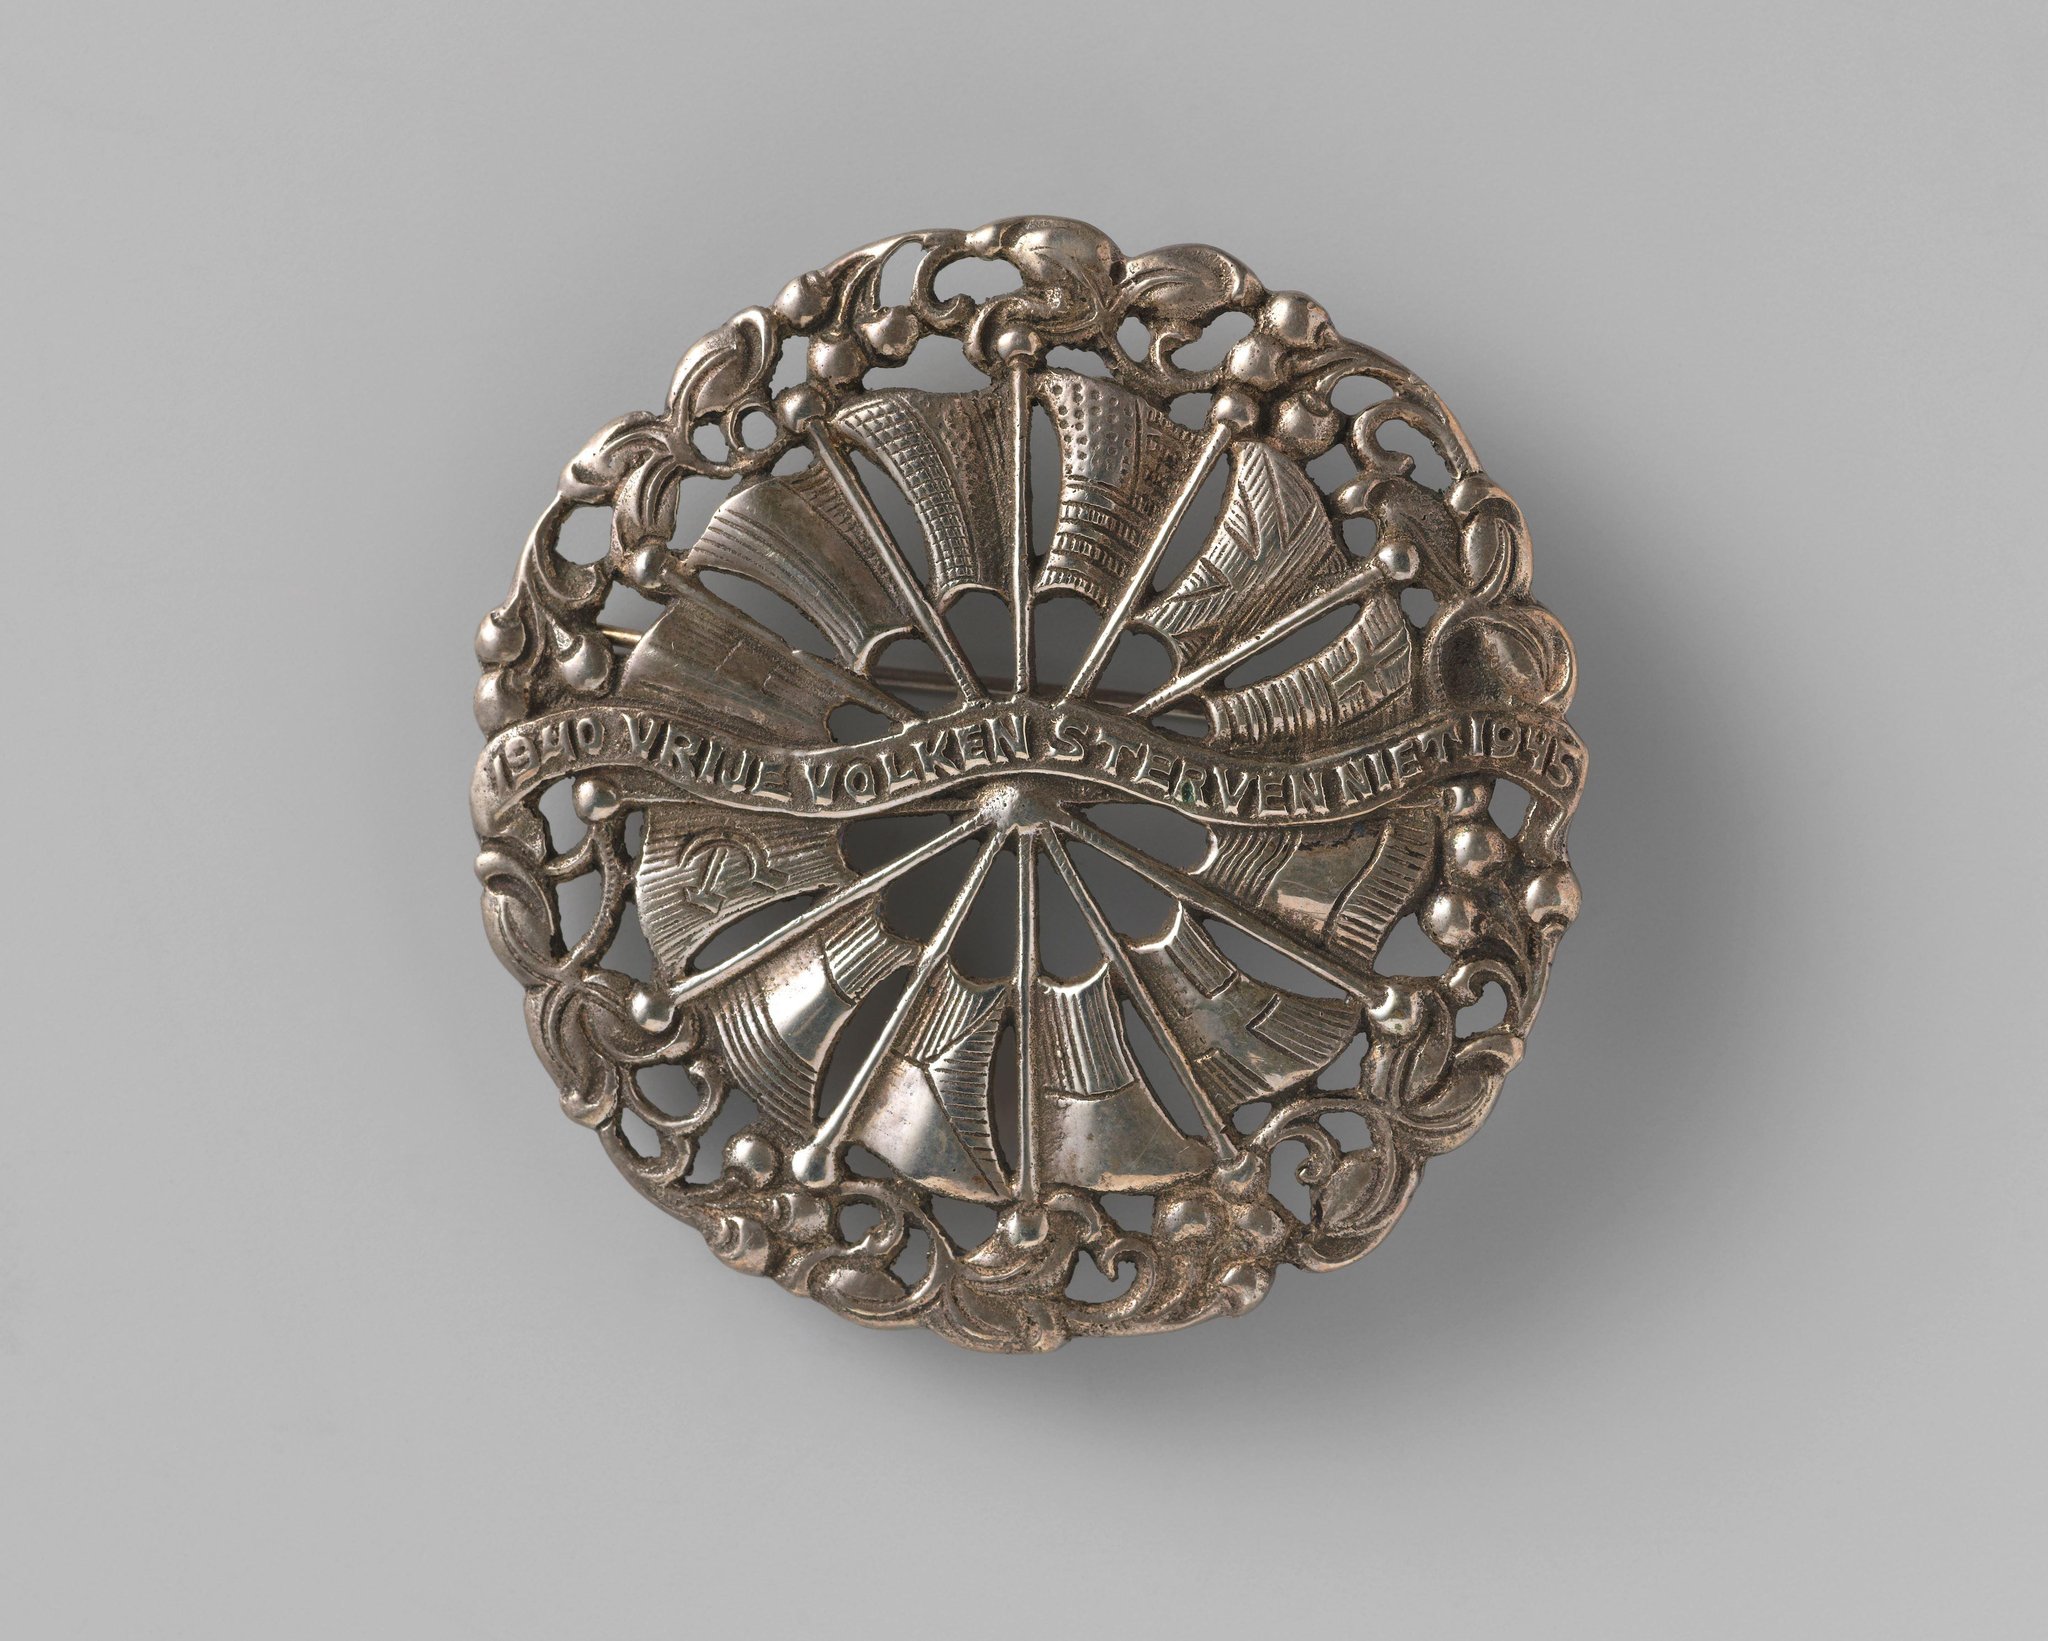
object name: brooch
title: Brooch ‘Free peoples never die’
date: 1944-1945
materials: silver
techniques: embroidery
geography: zandvoort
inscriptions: inscription: ‘1940 VRIJE VOLKEN STERVEN NIET 1945’, alloy mark: ‘zwaard’, maker's mark: ‘W2V’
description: Silent Resistance –War and Liberation Jewellery During the Second World War, small pieces of jewellery were worn in the Netherlands as a silent protest against the German occupier. In April 1941, Dutch coins were officially confiscated for the war industry. As jewellery did not have to be surrendered, coins were quickly transformed into rings, brooches, pins and bracelets. A portrait of Queen Wilhelmina was worn as a sign of resistance, as well as a token of loyalty to the royal family. Margriet Francisca, the third daughter of Princess Juliana and Prince Bernard, was born in Canada in January 1943. The pin with the three yellow chicks refers to the three young princesses Beatrix, Irene and Margriet and the steadfastness of the Dutch royal family. After the liberation, coins and silver were used for jewellery conveying messages of hope for a peaceful future.